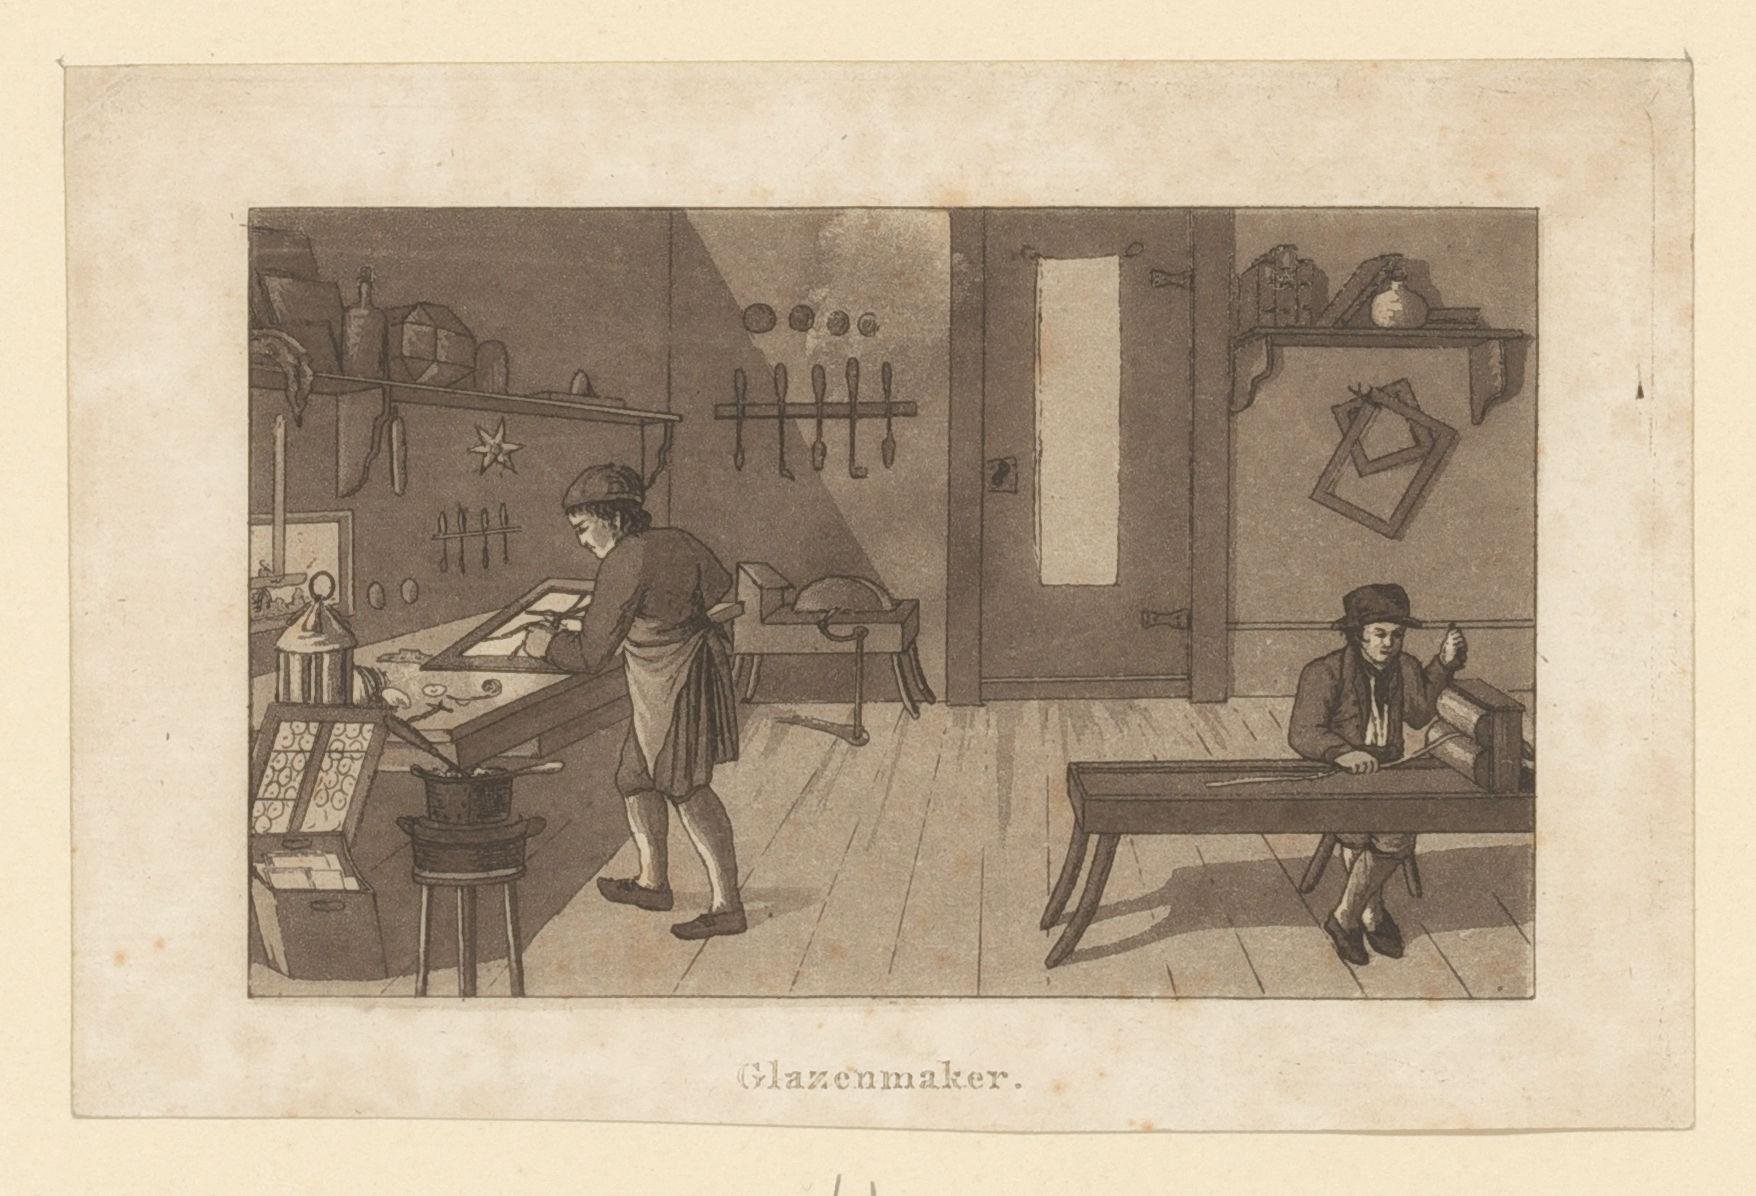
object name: print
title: Glazenmaker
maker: Anonymous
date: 1809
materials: paper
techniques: aquatint, etching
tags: handicrafts, craftsman at work, glass-maker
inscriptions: stamp, collector's mark: Lugt 1641, stamp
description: Interieur van de werkplaats van een glas in lood maker. Onderwerpsrubrieken binnen de Atlas Zeden en Gewoonten: Handel, Nijverheid en verkeer, Beroep en bedrijf, Mannelijk, Glas en Aardewerk.